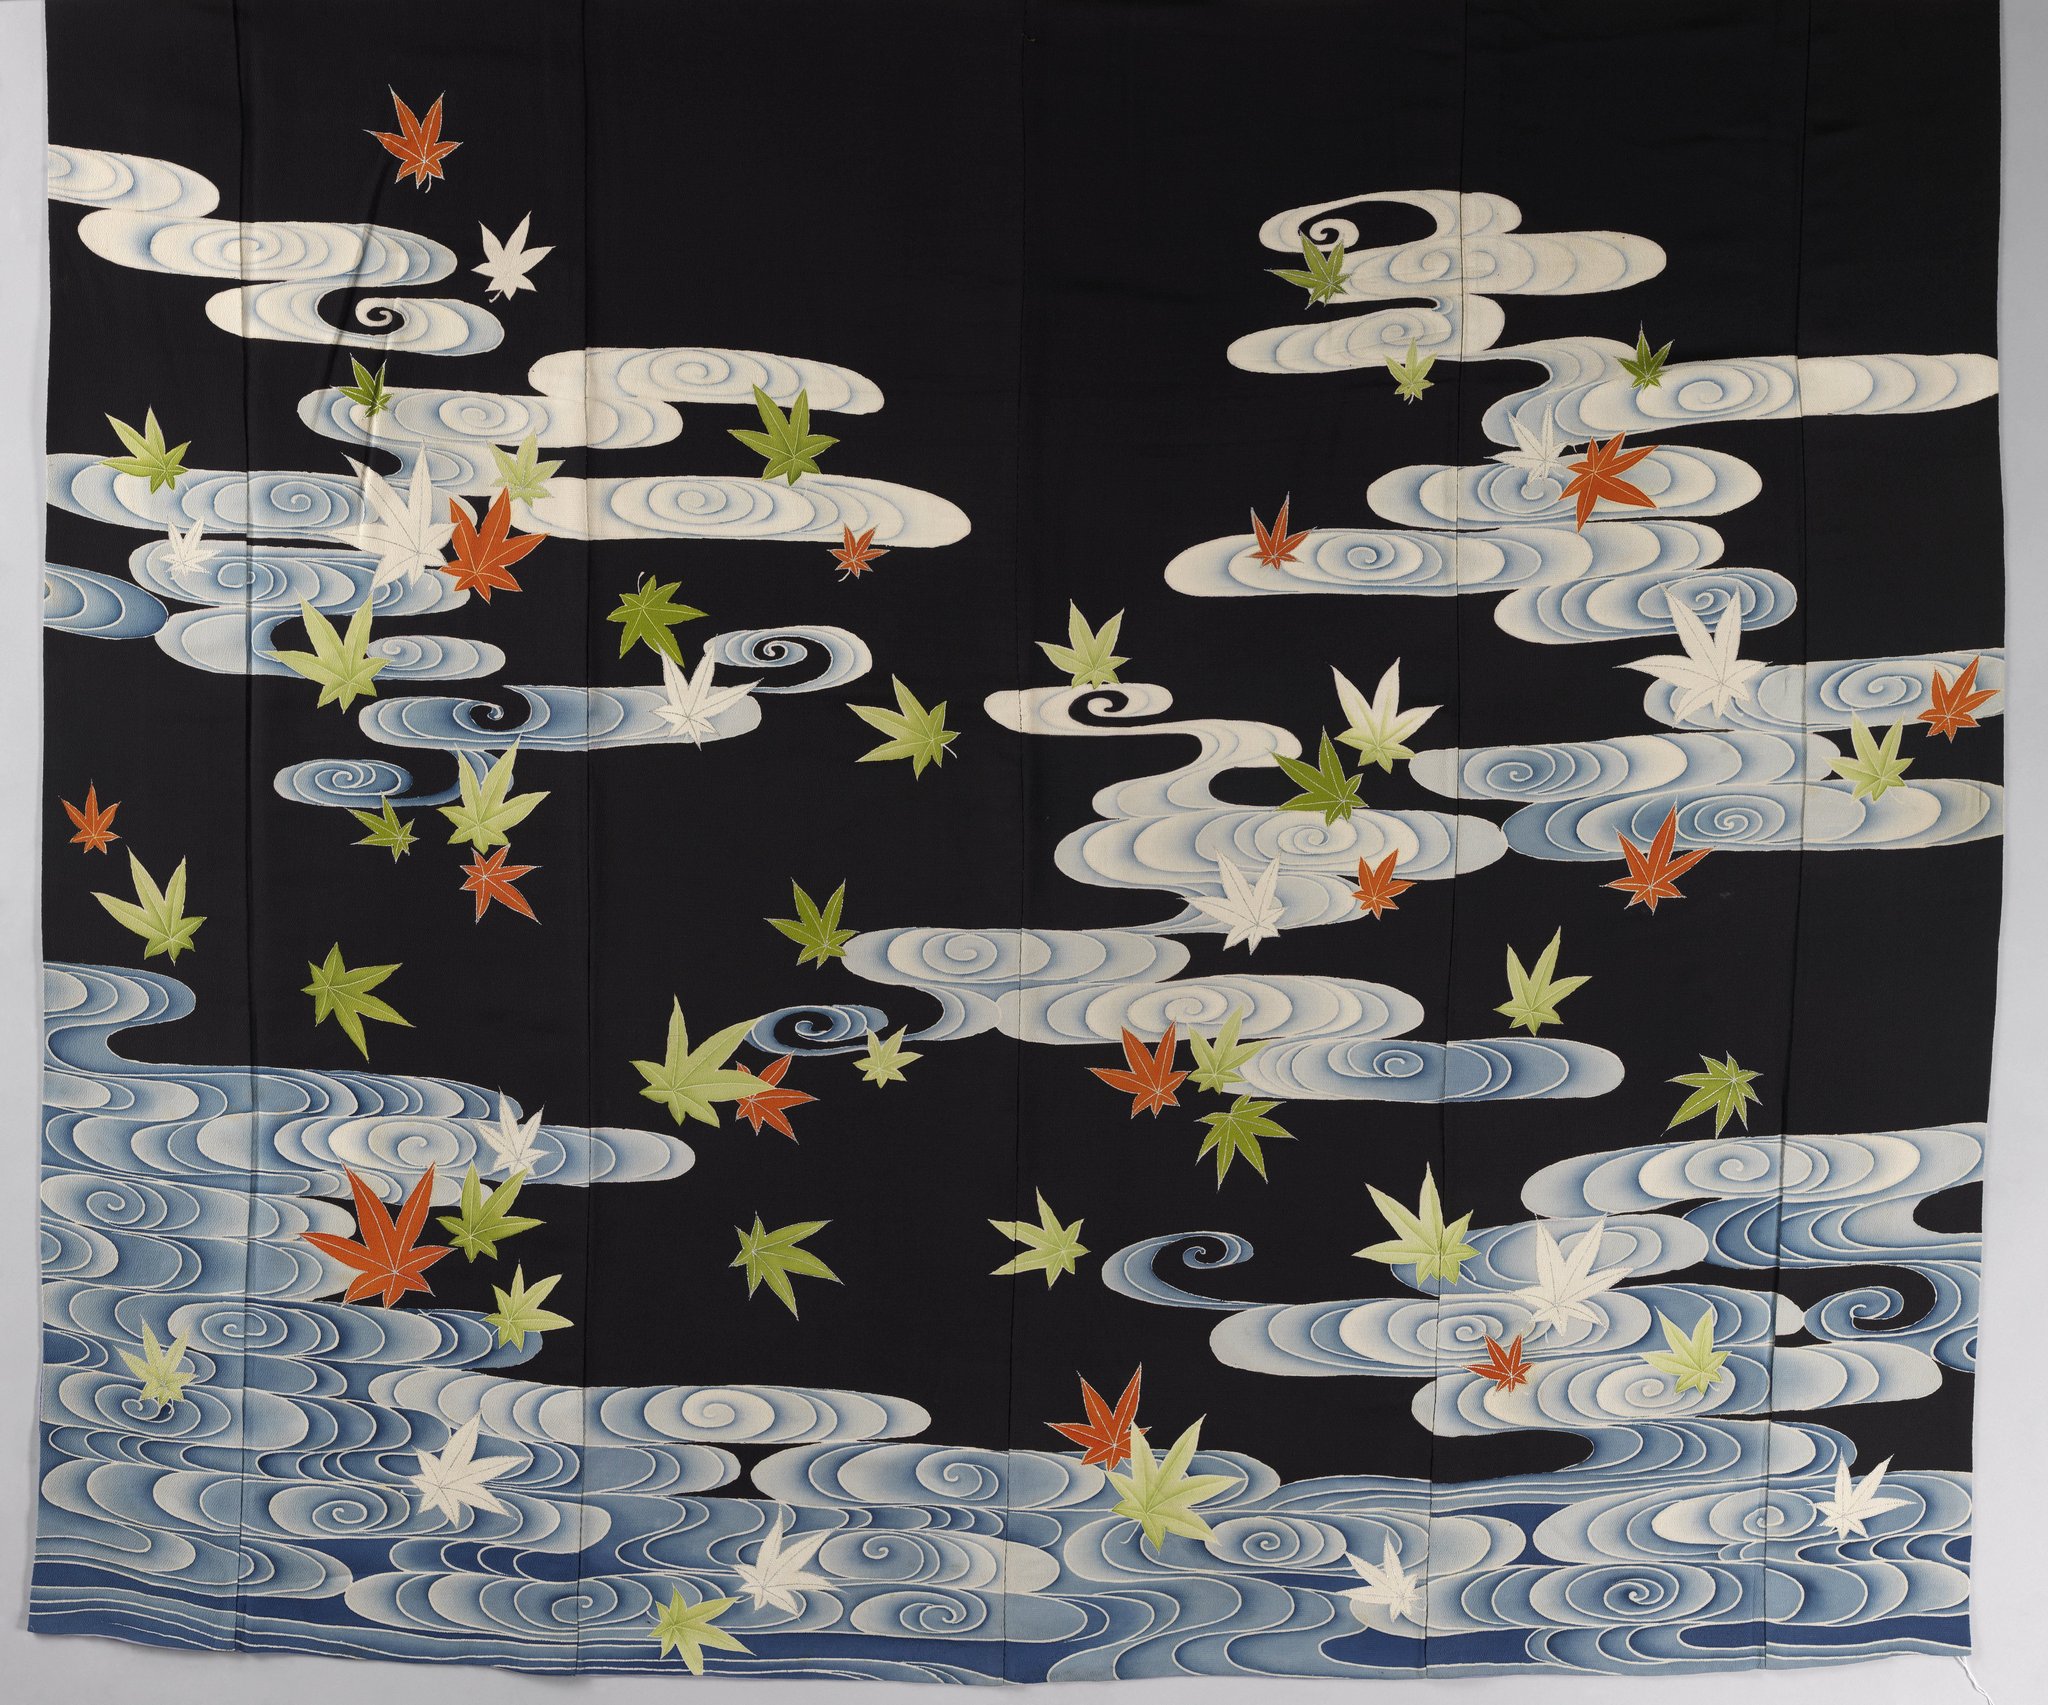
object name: kimono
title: Dance kimono for a geisha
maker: Anonymous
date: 1920-1940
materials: silk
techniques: painting, weave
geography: japan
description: Geishas (female entertainers) wore this kind of long kimono to dance in. The water motifs are well-suited to the flowing movements of the dancer. Together with the maple leaves, they refer to the Tatsuta River, where in the autumn the leaves float on the water like coloured brocade.